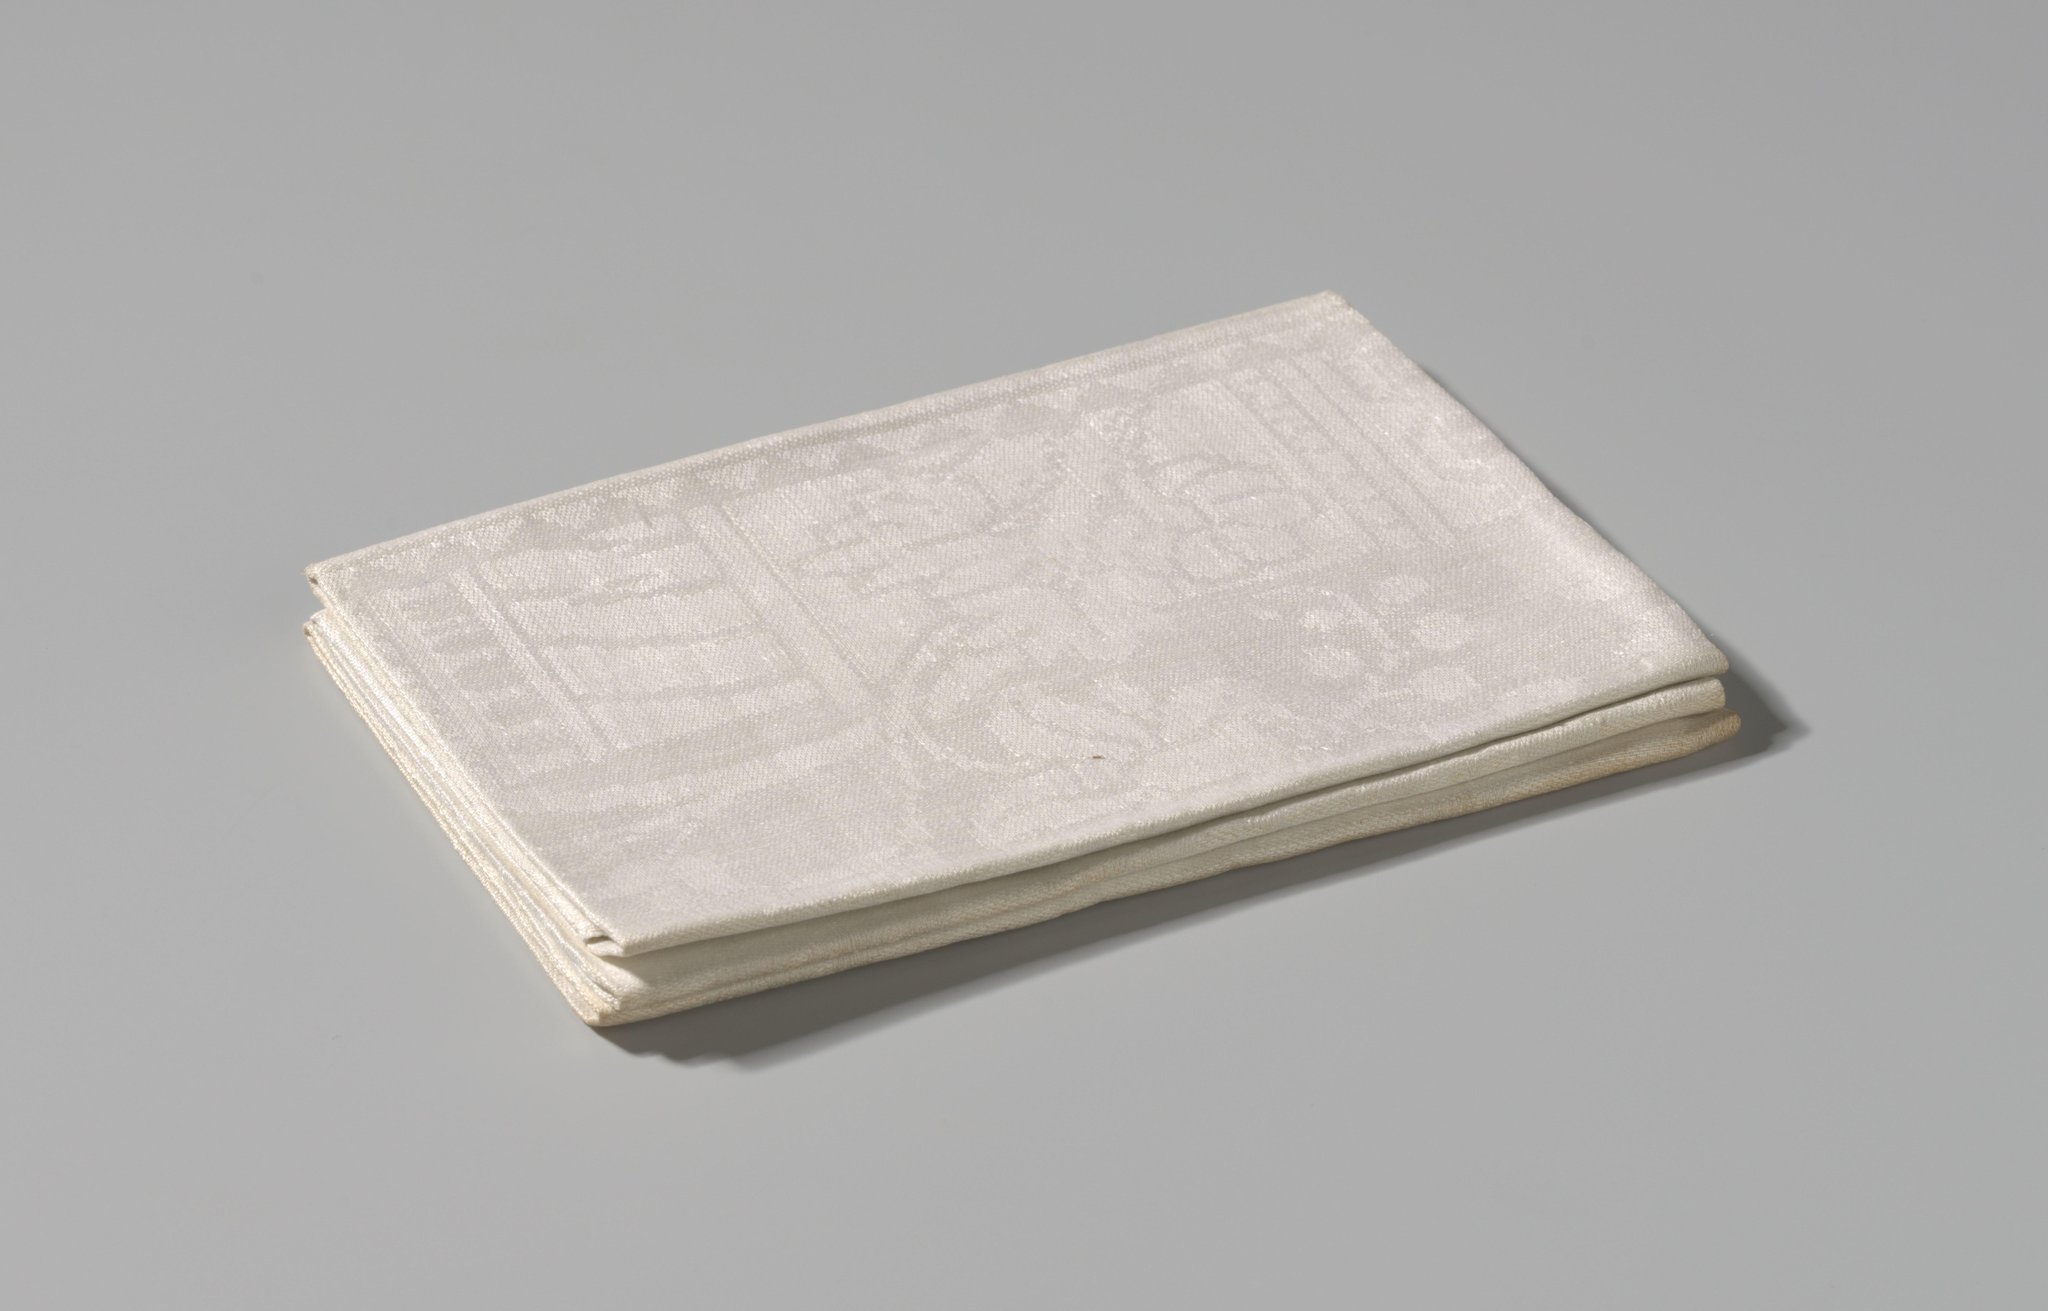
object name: tablecloth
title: Tafellaken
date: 1710-1715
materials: linen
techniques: damask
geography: northern netherlands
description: Wit linnendamasten tafellaken met een bizar patroon met zuilen.